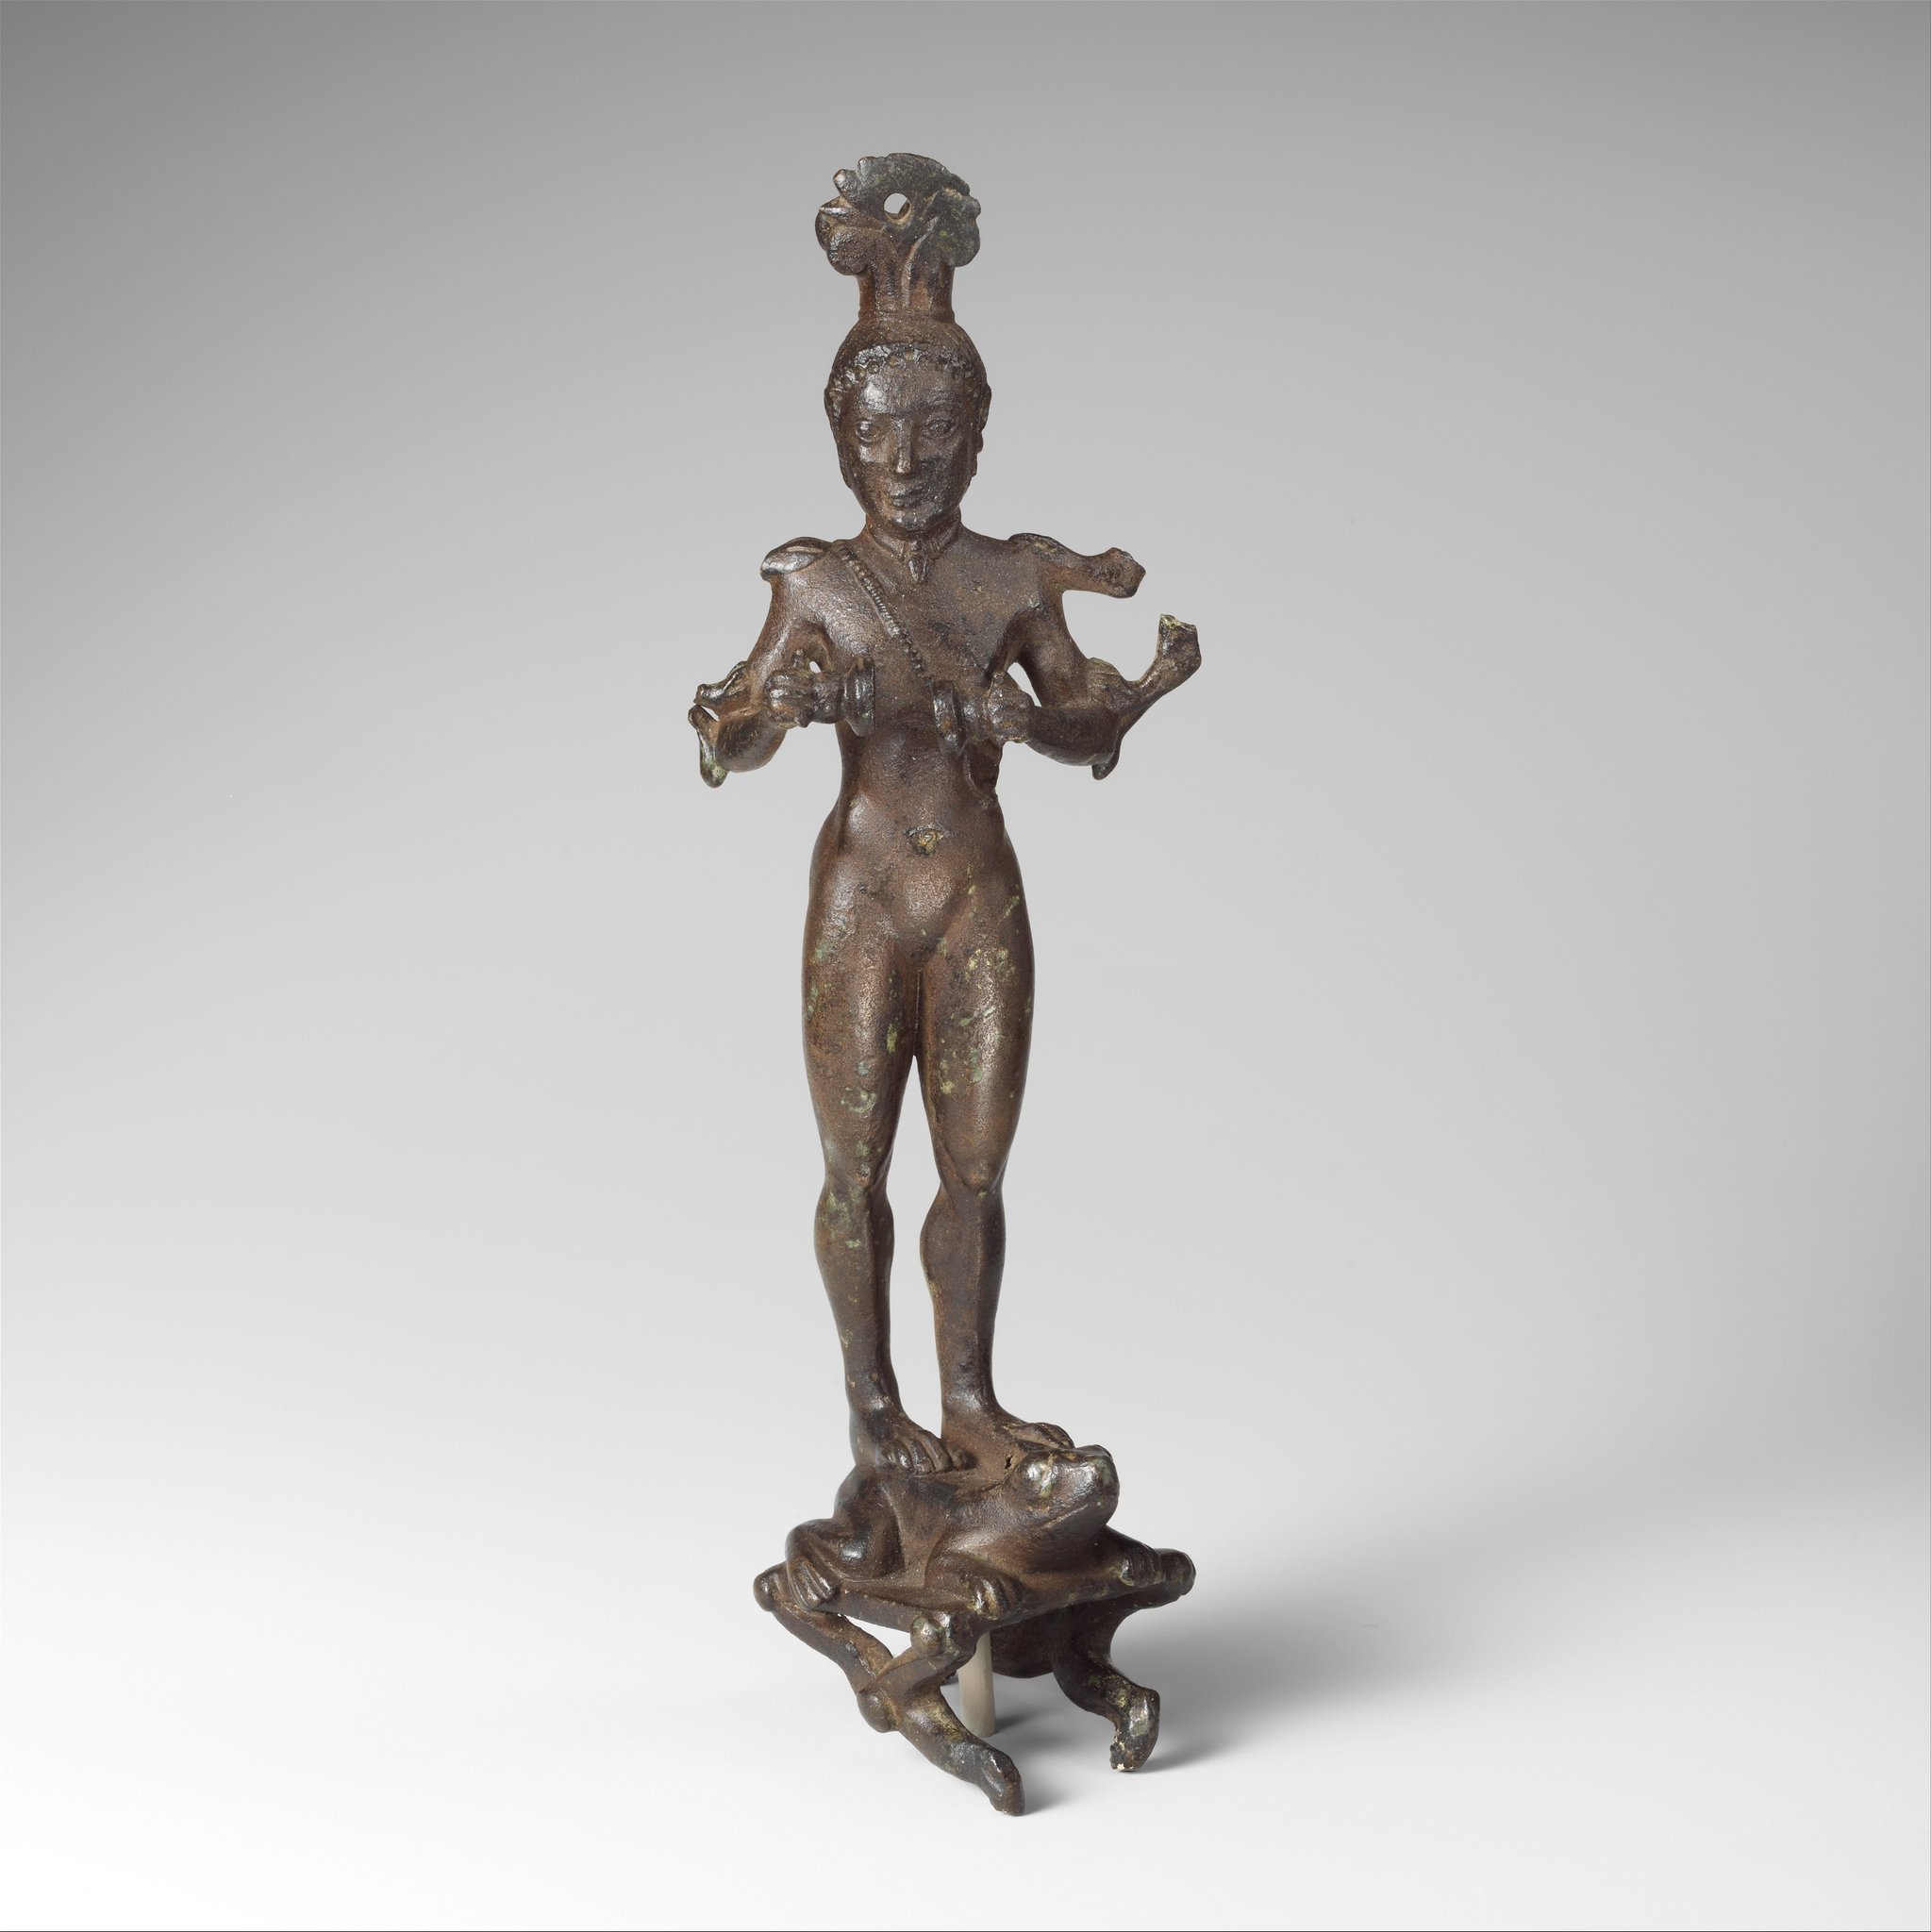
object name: mirror support, girl with frog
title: Bronze mirror support in the form of a nude girl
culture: greek, laconian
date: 540-530 BCE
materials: bronze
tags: female nudes,frogs